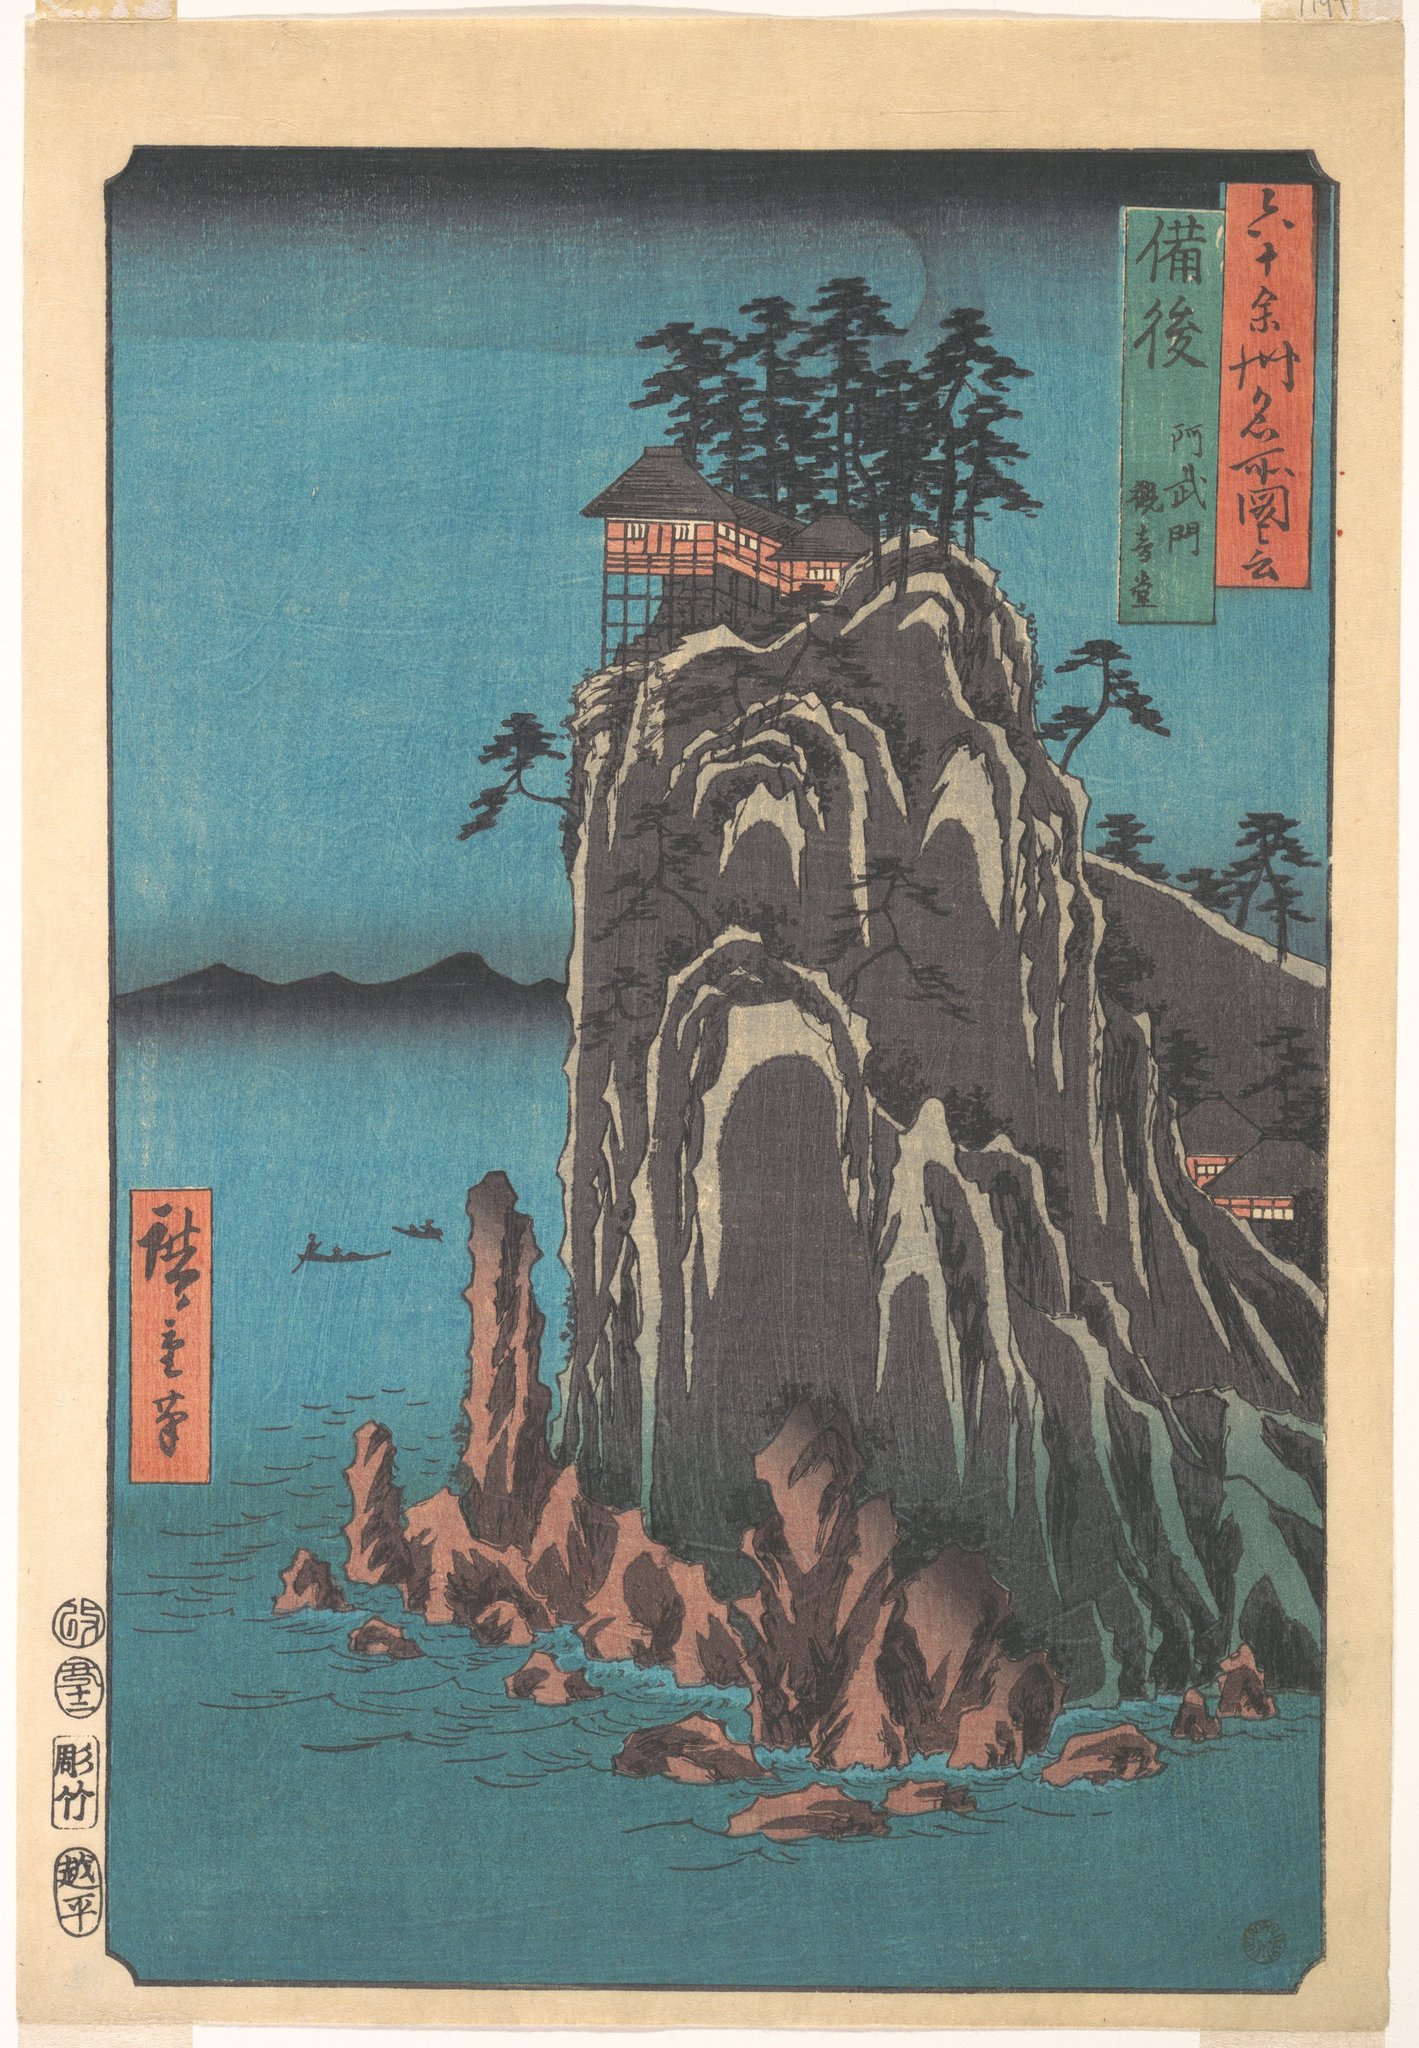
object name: print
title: Kannondo, Abuto, Bingo Province, from the series Views of Famous Places in the Sixty-Odd Provinces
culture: japanese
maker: utagawa hiroshige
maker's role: artist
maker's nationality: japanese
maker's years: 1797-1858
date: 1853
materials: ink, paper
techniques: woodblock print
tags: mountains,landscapes